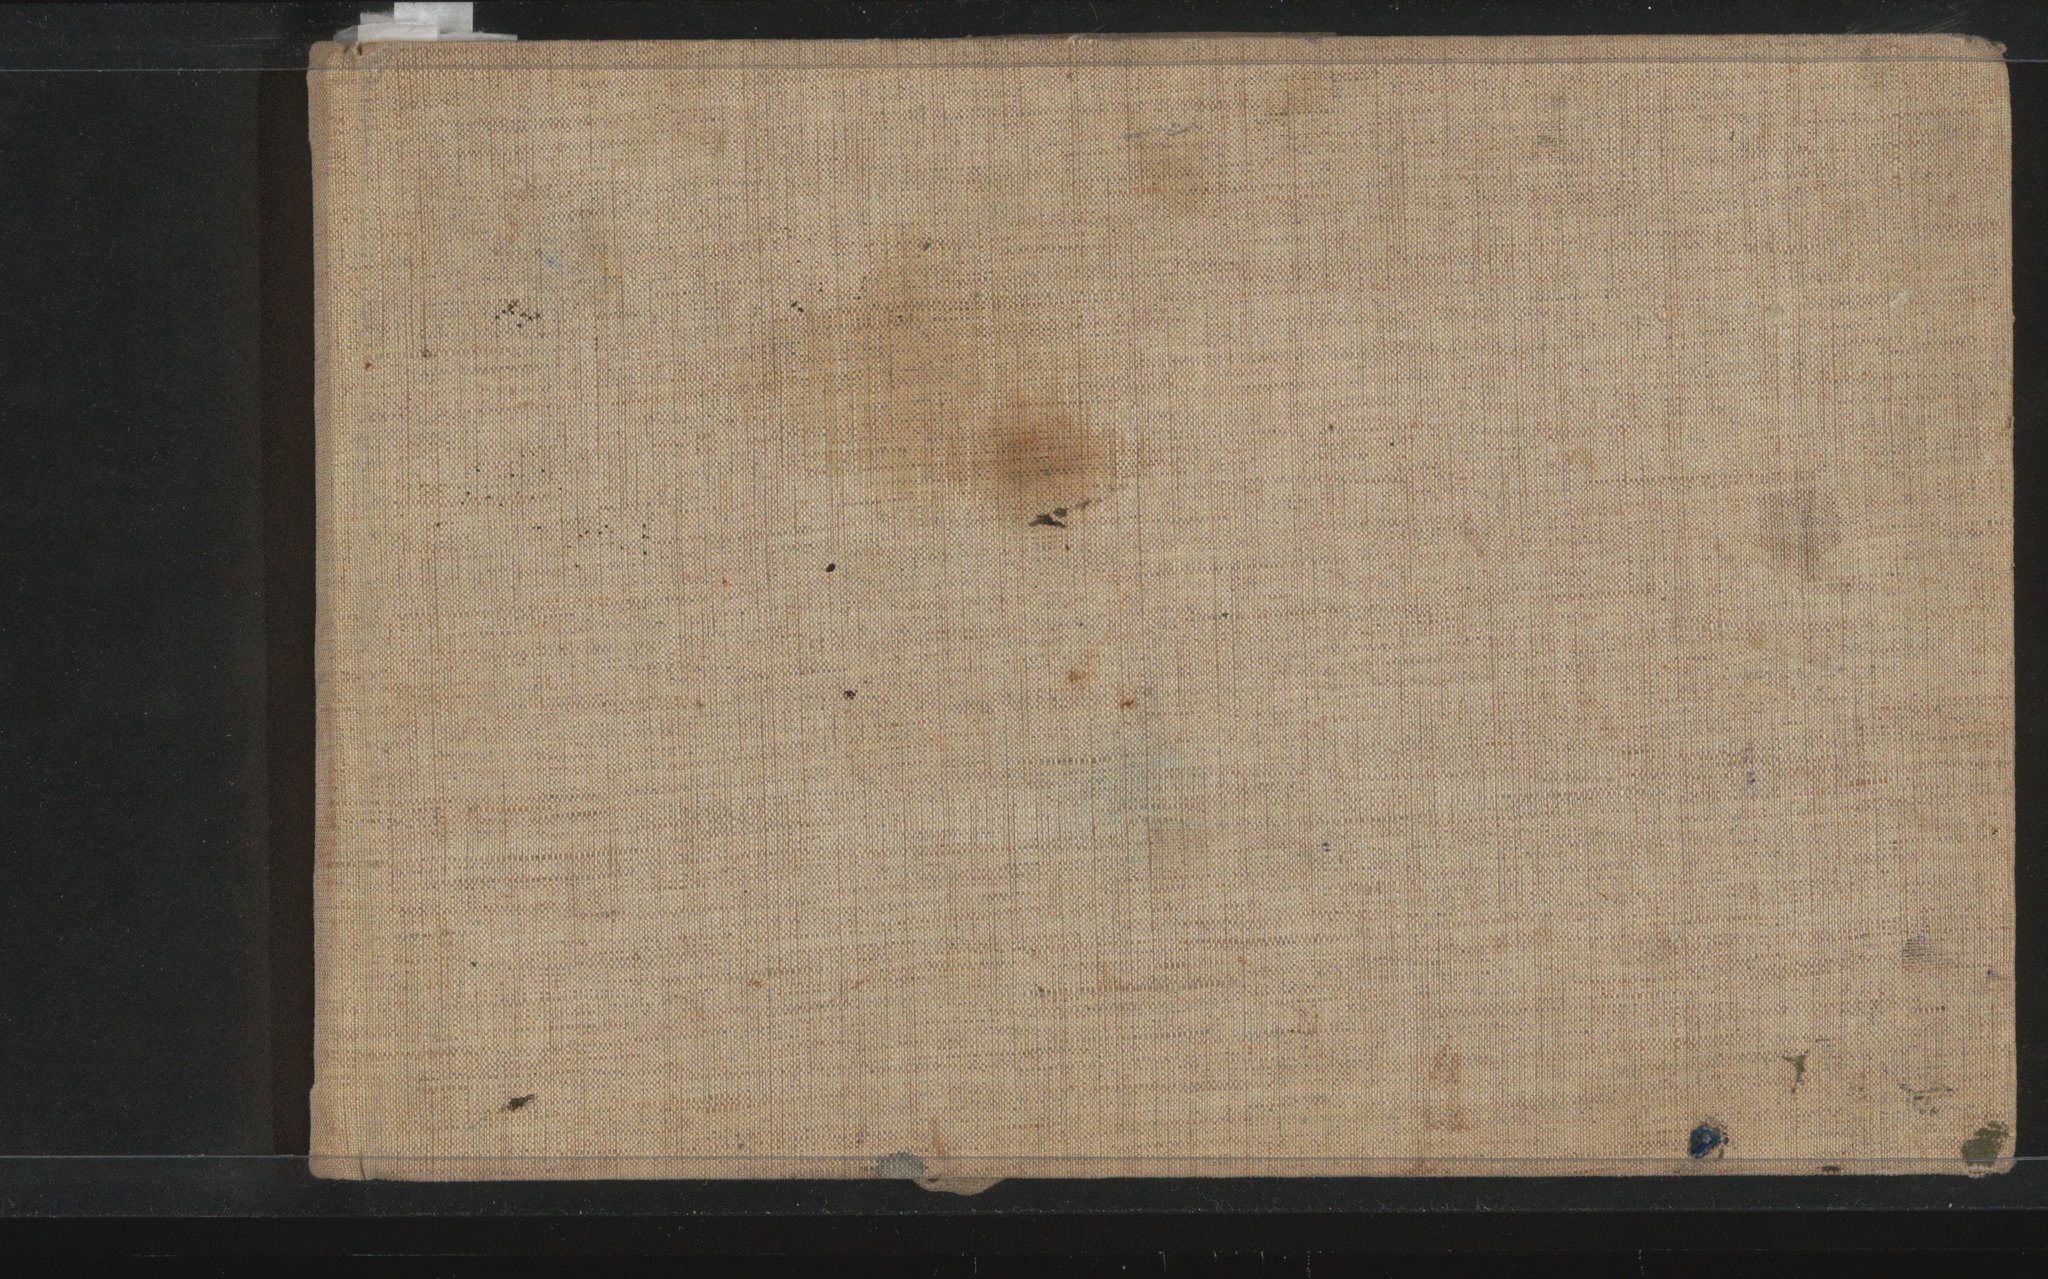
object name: sketchbook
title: Schetsboek met 65 bladen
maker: a.a.l. de grammont-hubrecht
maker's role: draughtsman, painter, print maker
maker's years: 1855-1913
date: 1865-1913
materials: cardboard, chalk, charcoal, ink, linen, paper, pencil, watercolor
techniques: brush, pen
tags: head (human), landscapes, anatomy (non-medical)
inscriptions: collector's mark: Lugt 2228a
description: De volgende bladen zijn blanco: 46(R), 47(R), 48(R), 49(R), 51(R), 52(R), 53(R), 57, 59, 62 en 65(R). De verso van de bladen in het schetsboek zijn ook blanco, met uitzondering van bladen 4(V), 26(V), 37(V), 38(V), 43(V) t/m 53(V), 55(V), 56(V), 60(V), 61(V) en 63(V).